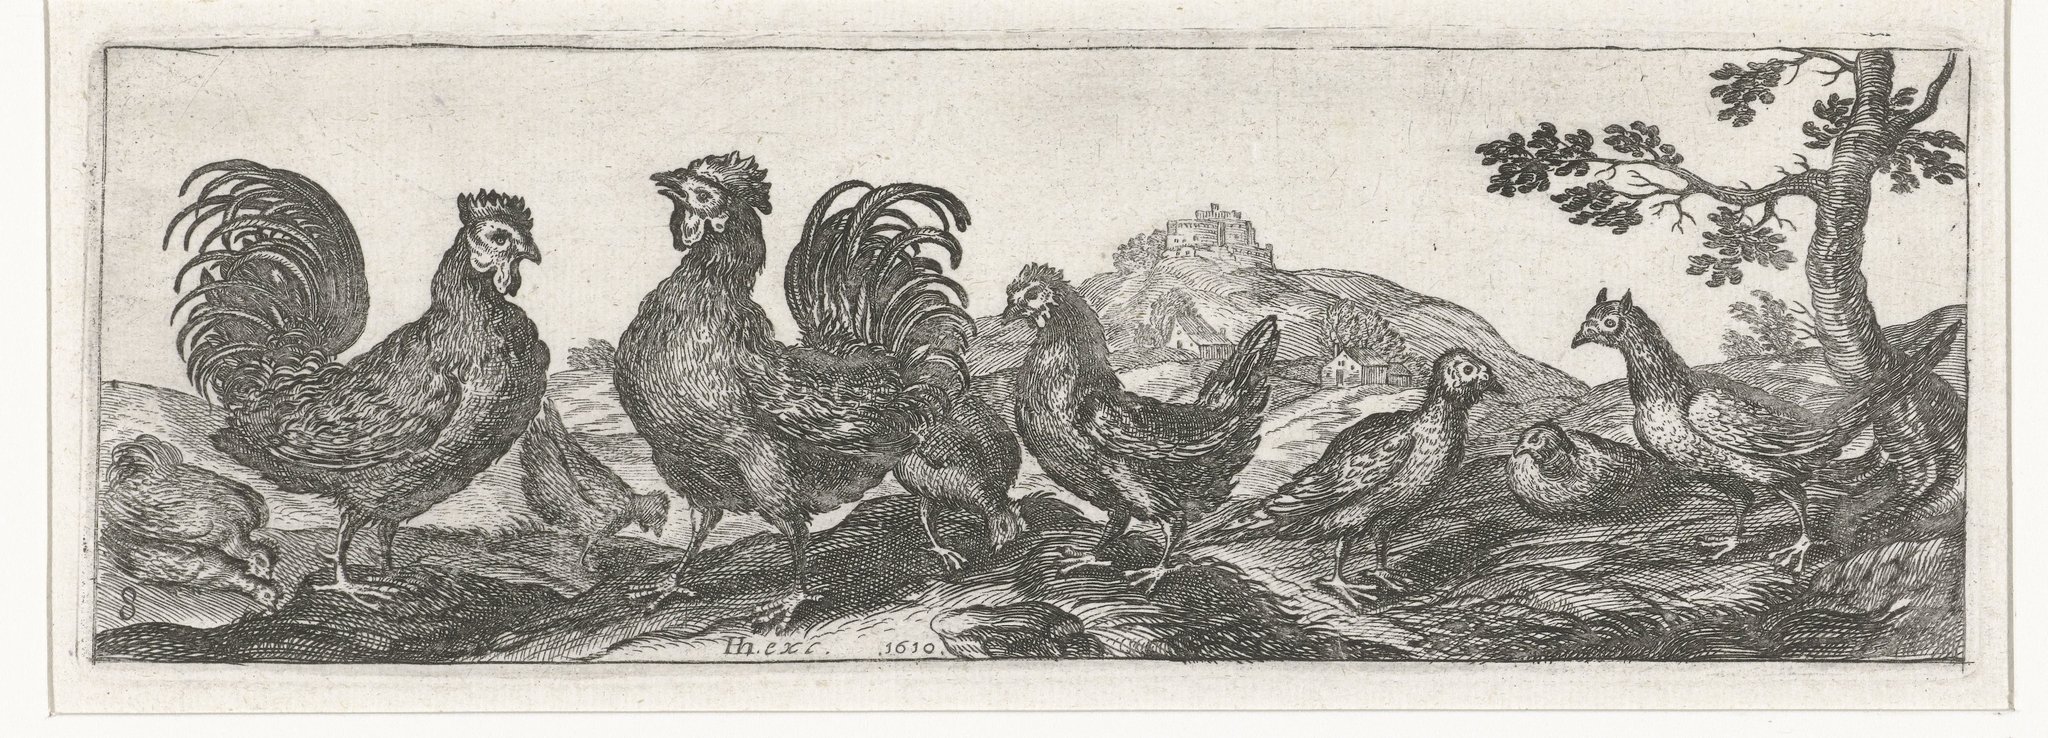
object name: print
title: Vogels en insecten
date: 1610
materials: paper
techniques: engraving, etching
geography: the hague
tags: groups of birds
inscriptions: collector's mark: Lugt 240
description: Landschap met hanen, hennen en fazanten.